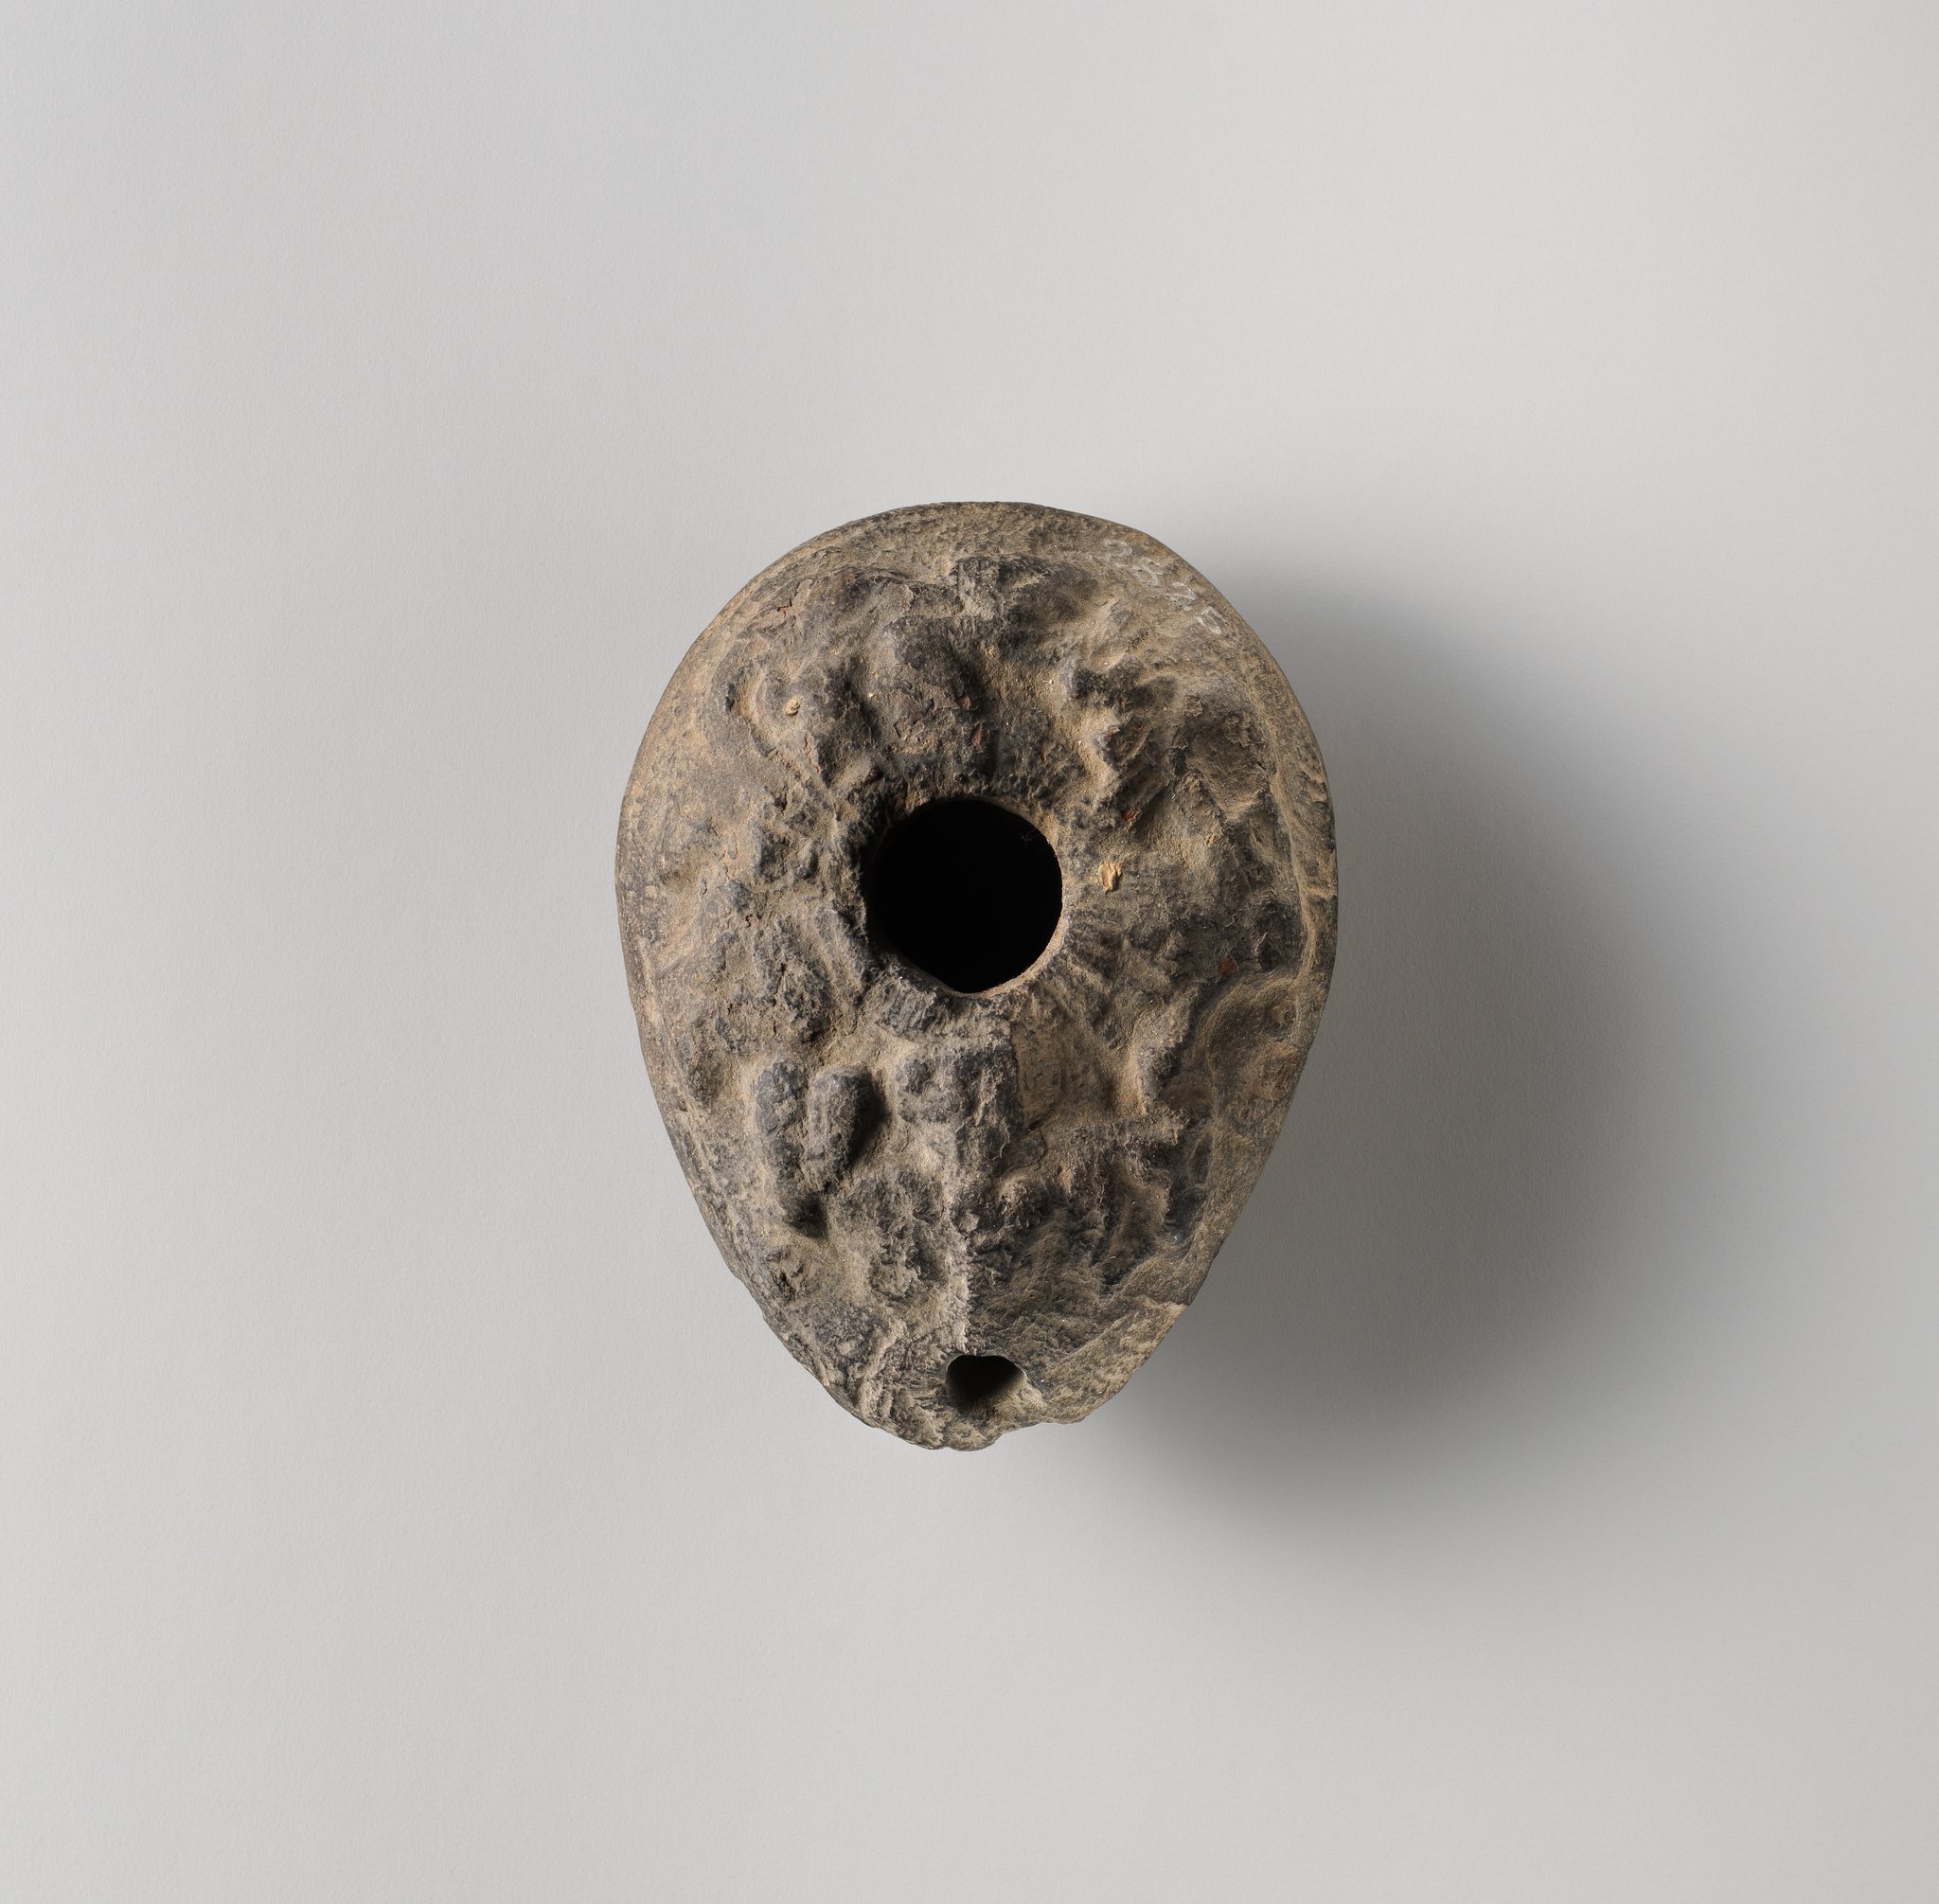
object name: lamp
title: Terracotta oil lamp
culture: roman, egyptian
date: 201-300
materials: terracotta